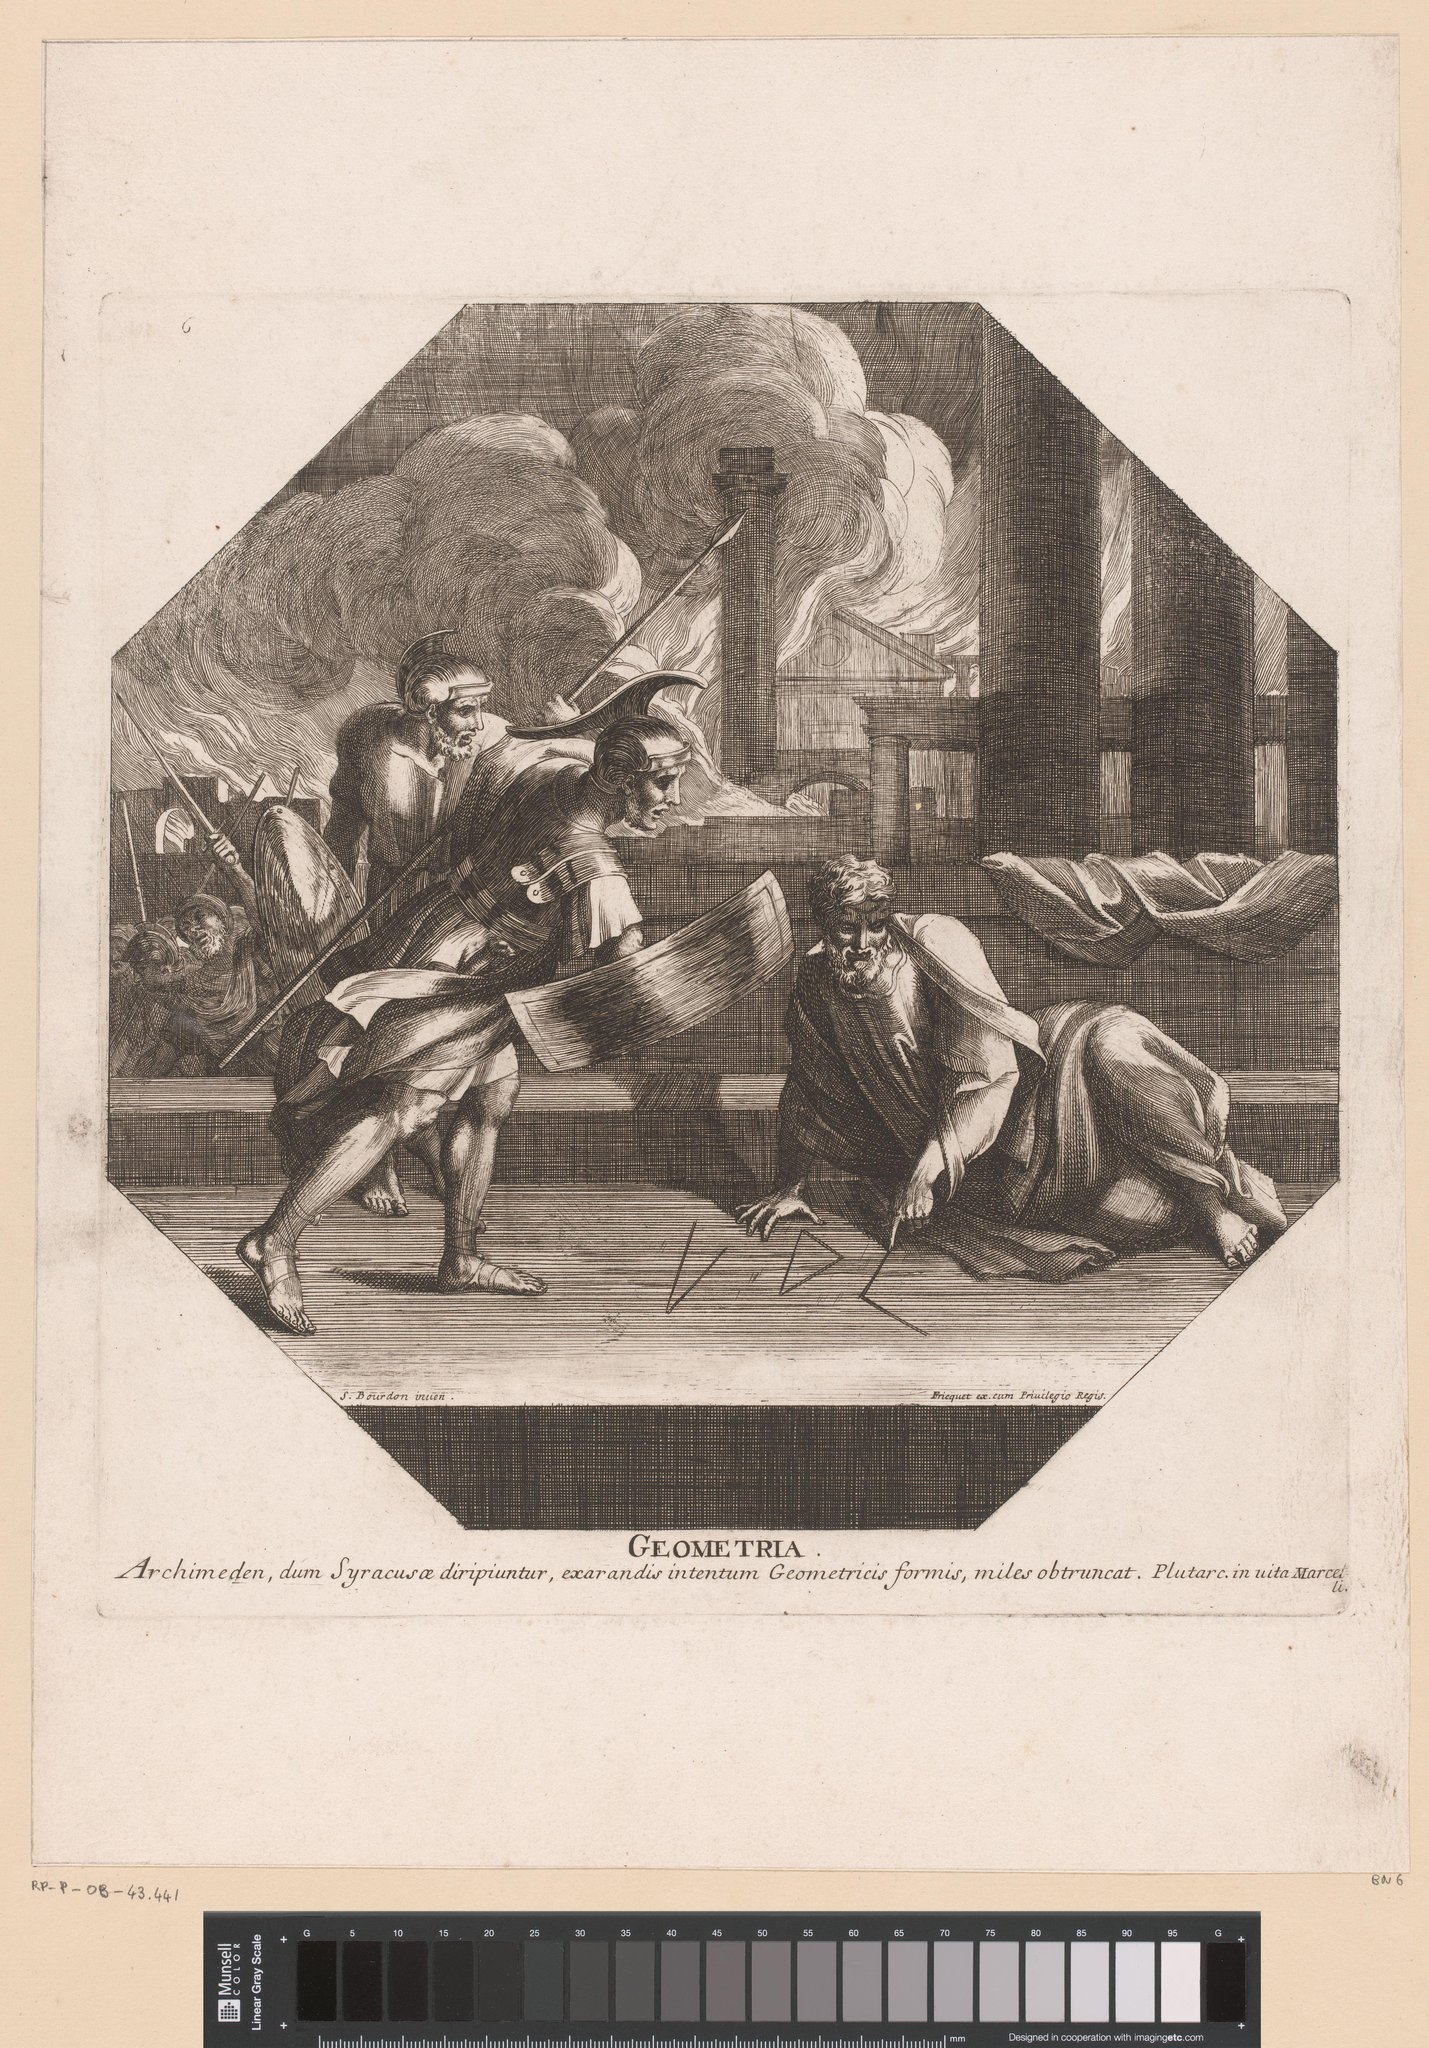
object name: print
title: Geometria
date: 1663-1716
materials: paper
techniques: engraving, etching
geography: france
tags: physicist, 'geometria' (~ quadrivium); 'geometria' (ripa), historical persons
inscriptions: collector's mark: Lugt 240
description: Maakt deel uit van een veertiendelige serie opgedeeld in twee reeksen, met als onderwerp de zeven vrije kunsten en deugden naar schilderijen door Sébastien Bourdon. De schilderijen werden in 1663 vervaardigd voor de Grande Galerie van het Hôtel de Bretonvilliers te Parijs.